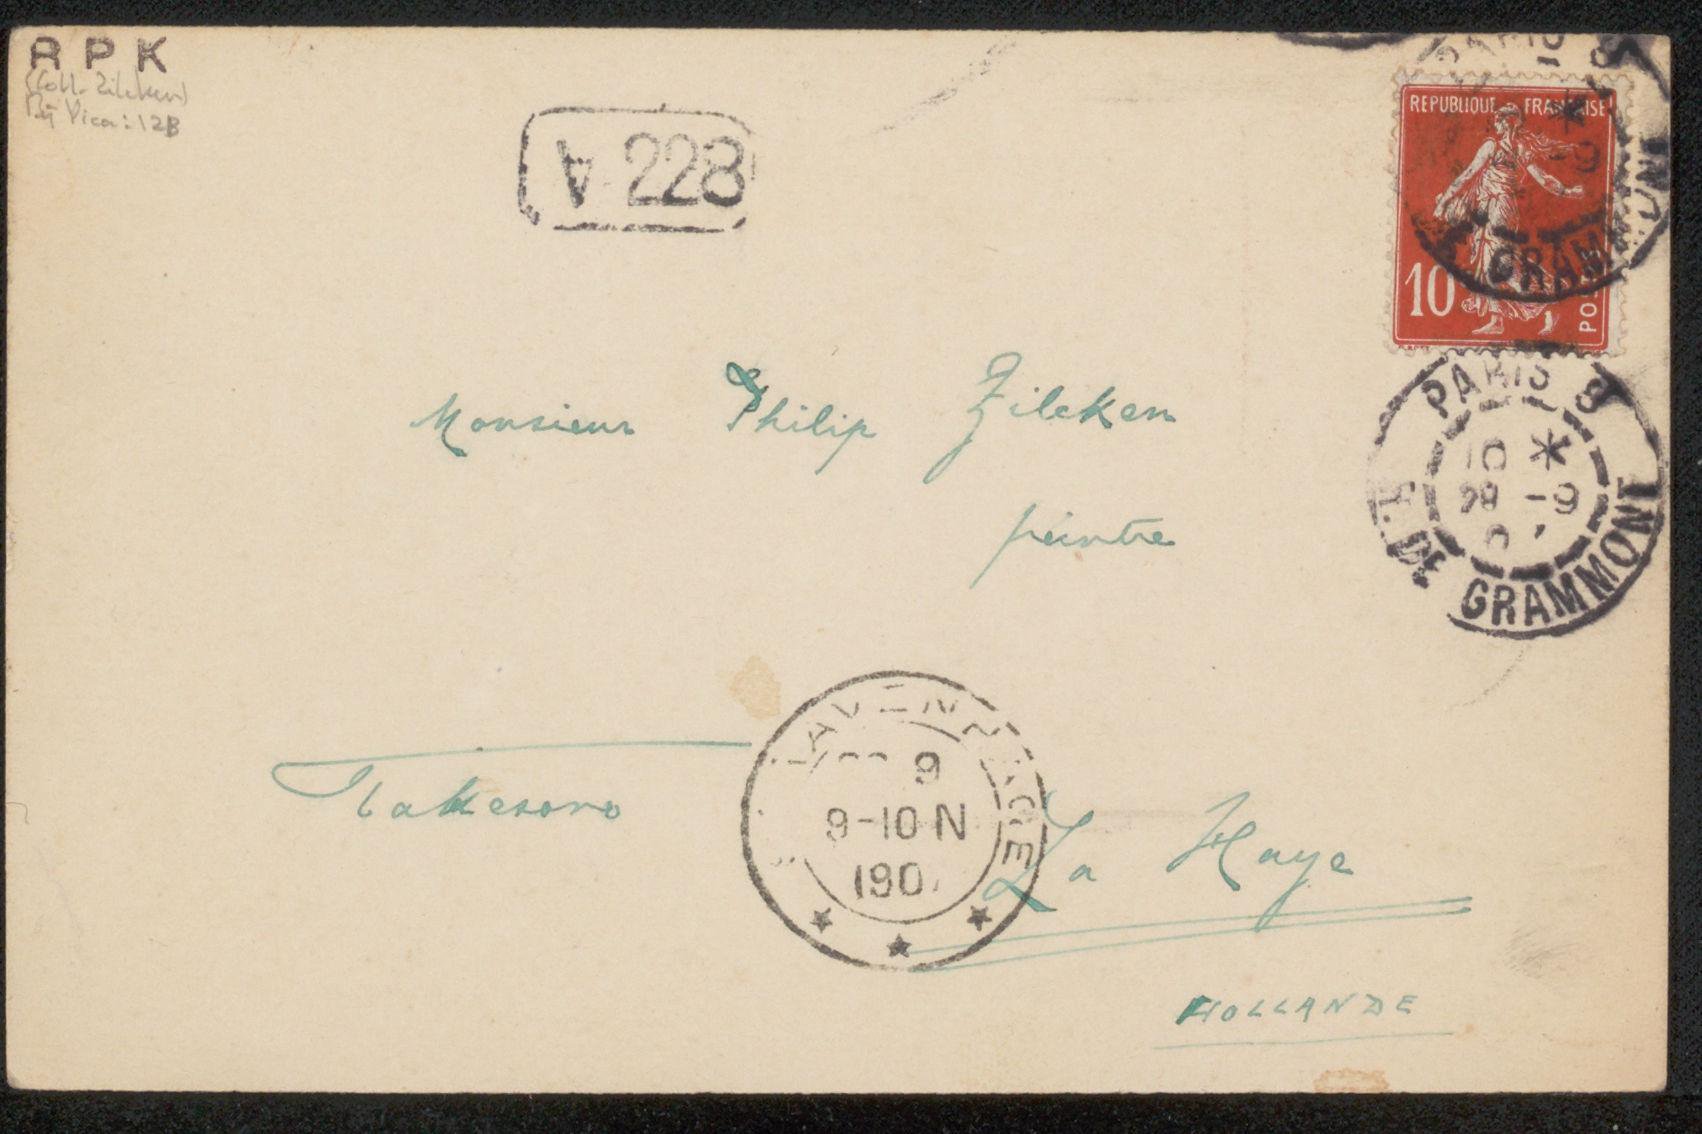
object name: letter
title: Brief aan Philip Zilcken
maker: vittorio pica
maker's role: criticus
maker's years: 1864-1930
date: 1907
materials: cardboard, ink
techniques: pen, printing, writing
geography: paris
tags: venice, rome, politician, antonio fradeletto, painter, draughtsman, philip zilcken, the graphic arts, exhibition ~ art, the hague, brussels, paris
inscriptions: collector's mark: ‘RPK’